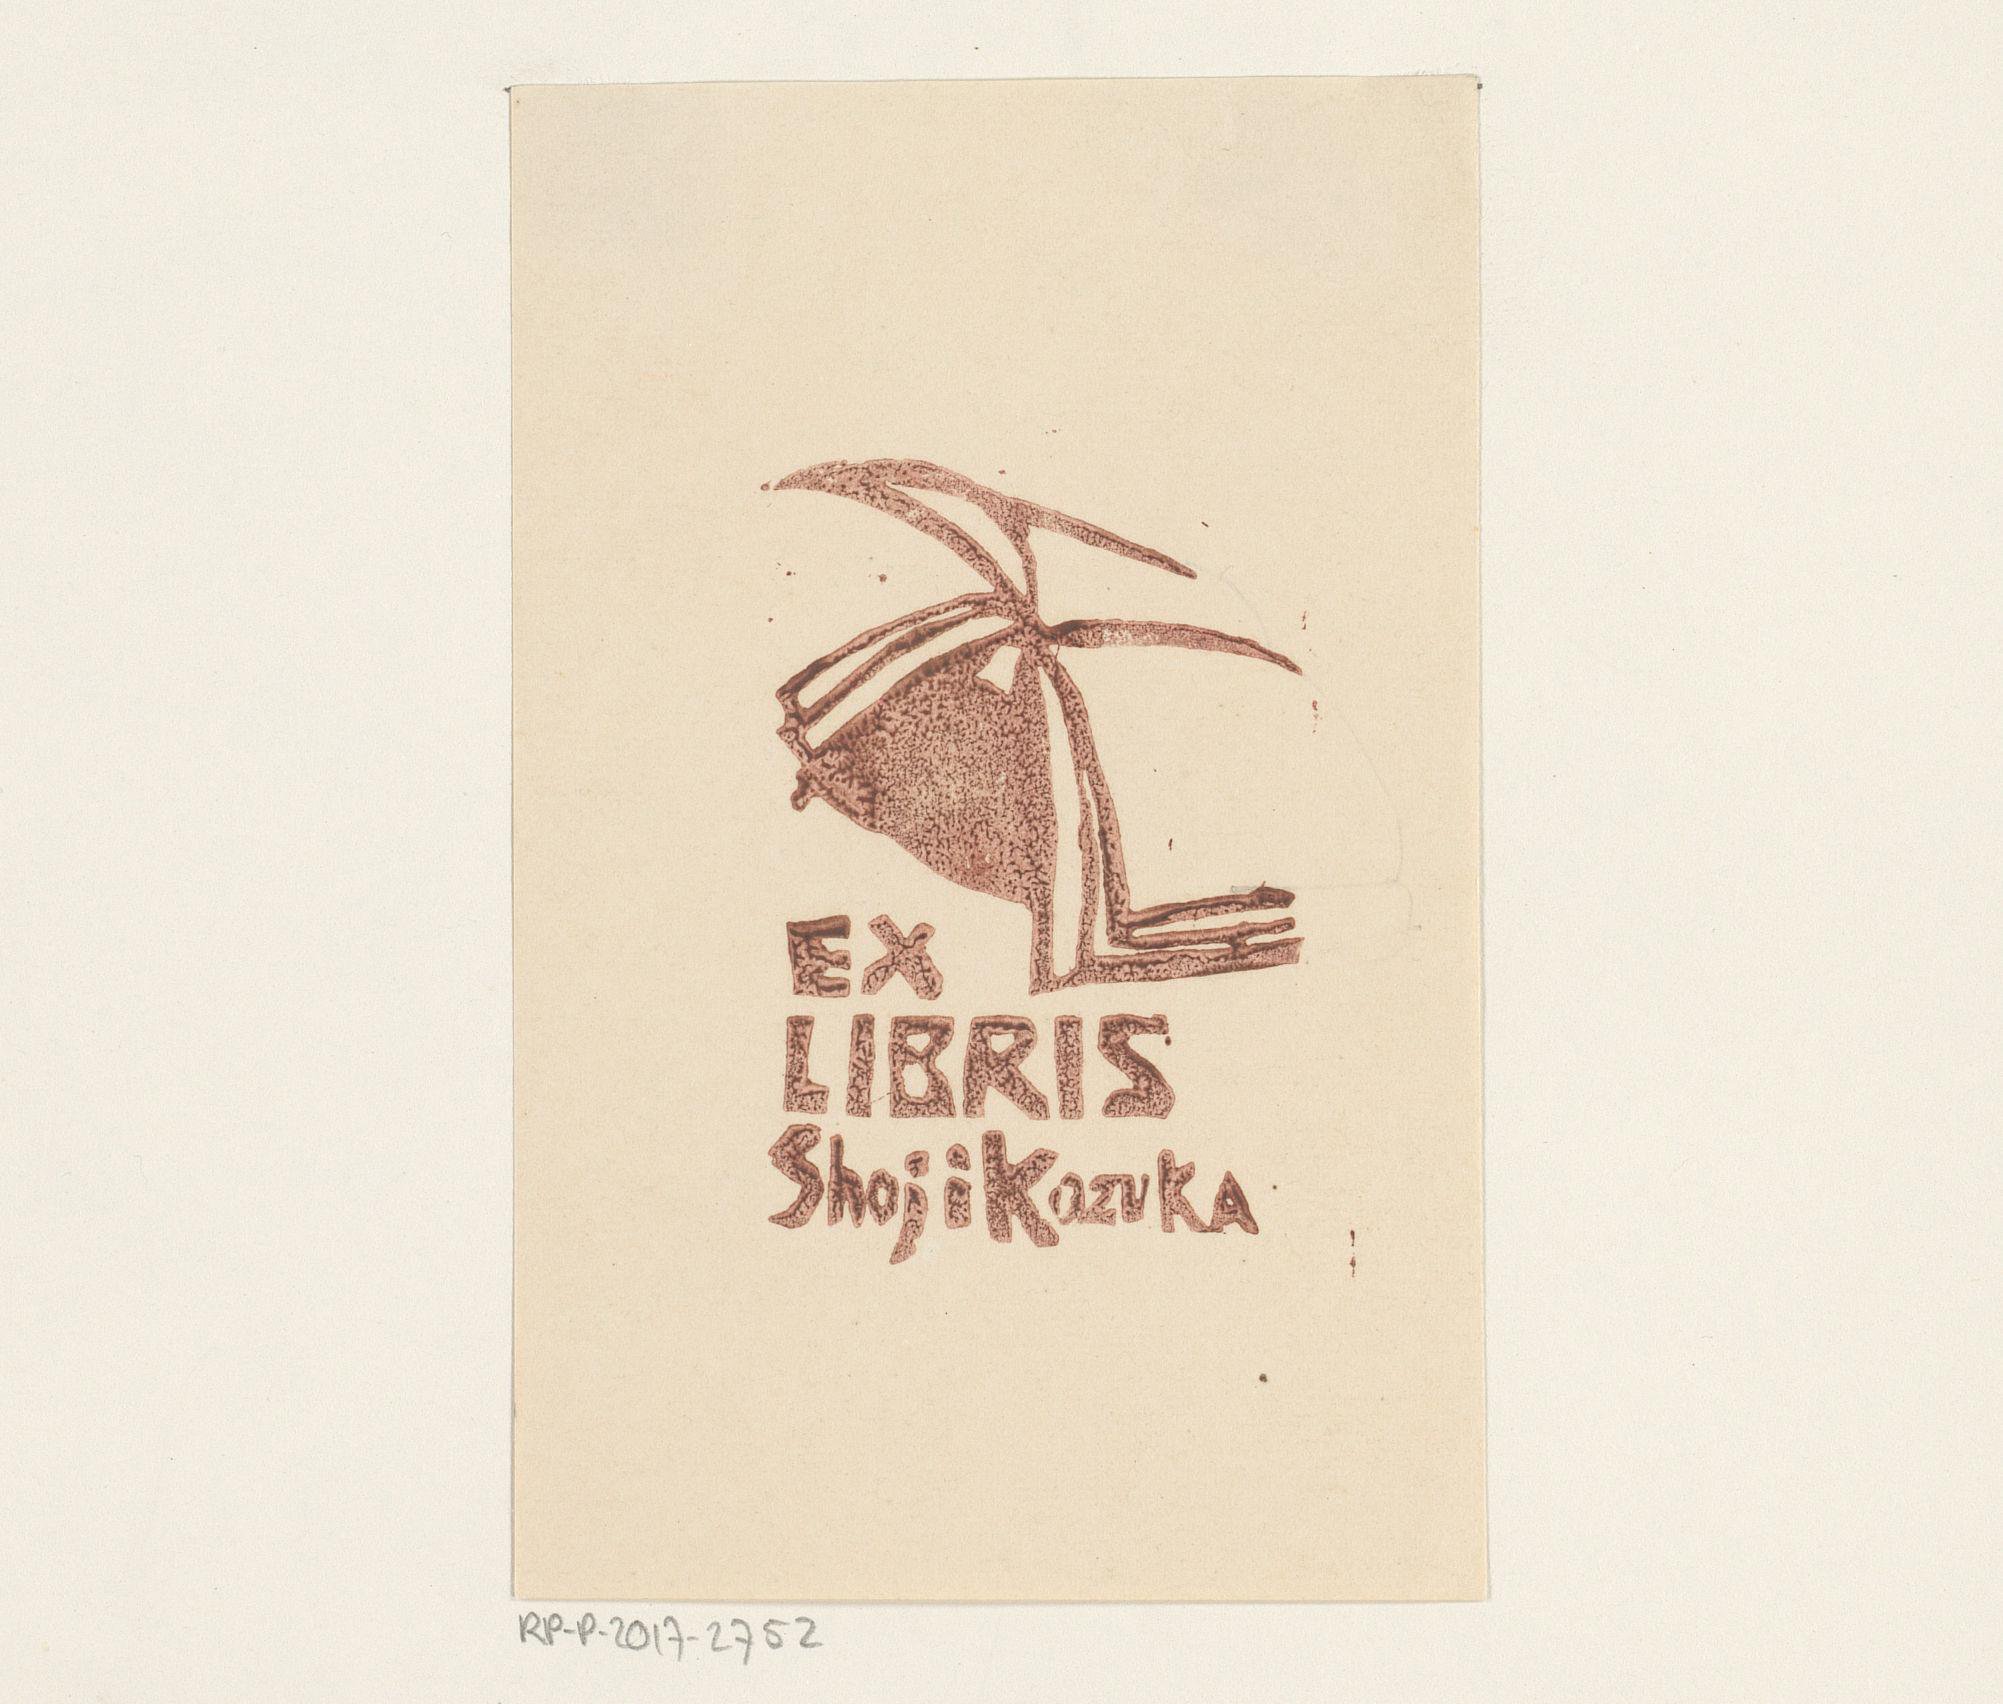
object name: bookplate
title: Ex libris van Shoji Kozuka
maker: Anonymous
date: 1900-1999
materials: paper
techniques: linocut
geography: japan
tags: shoji kozuka